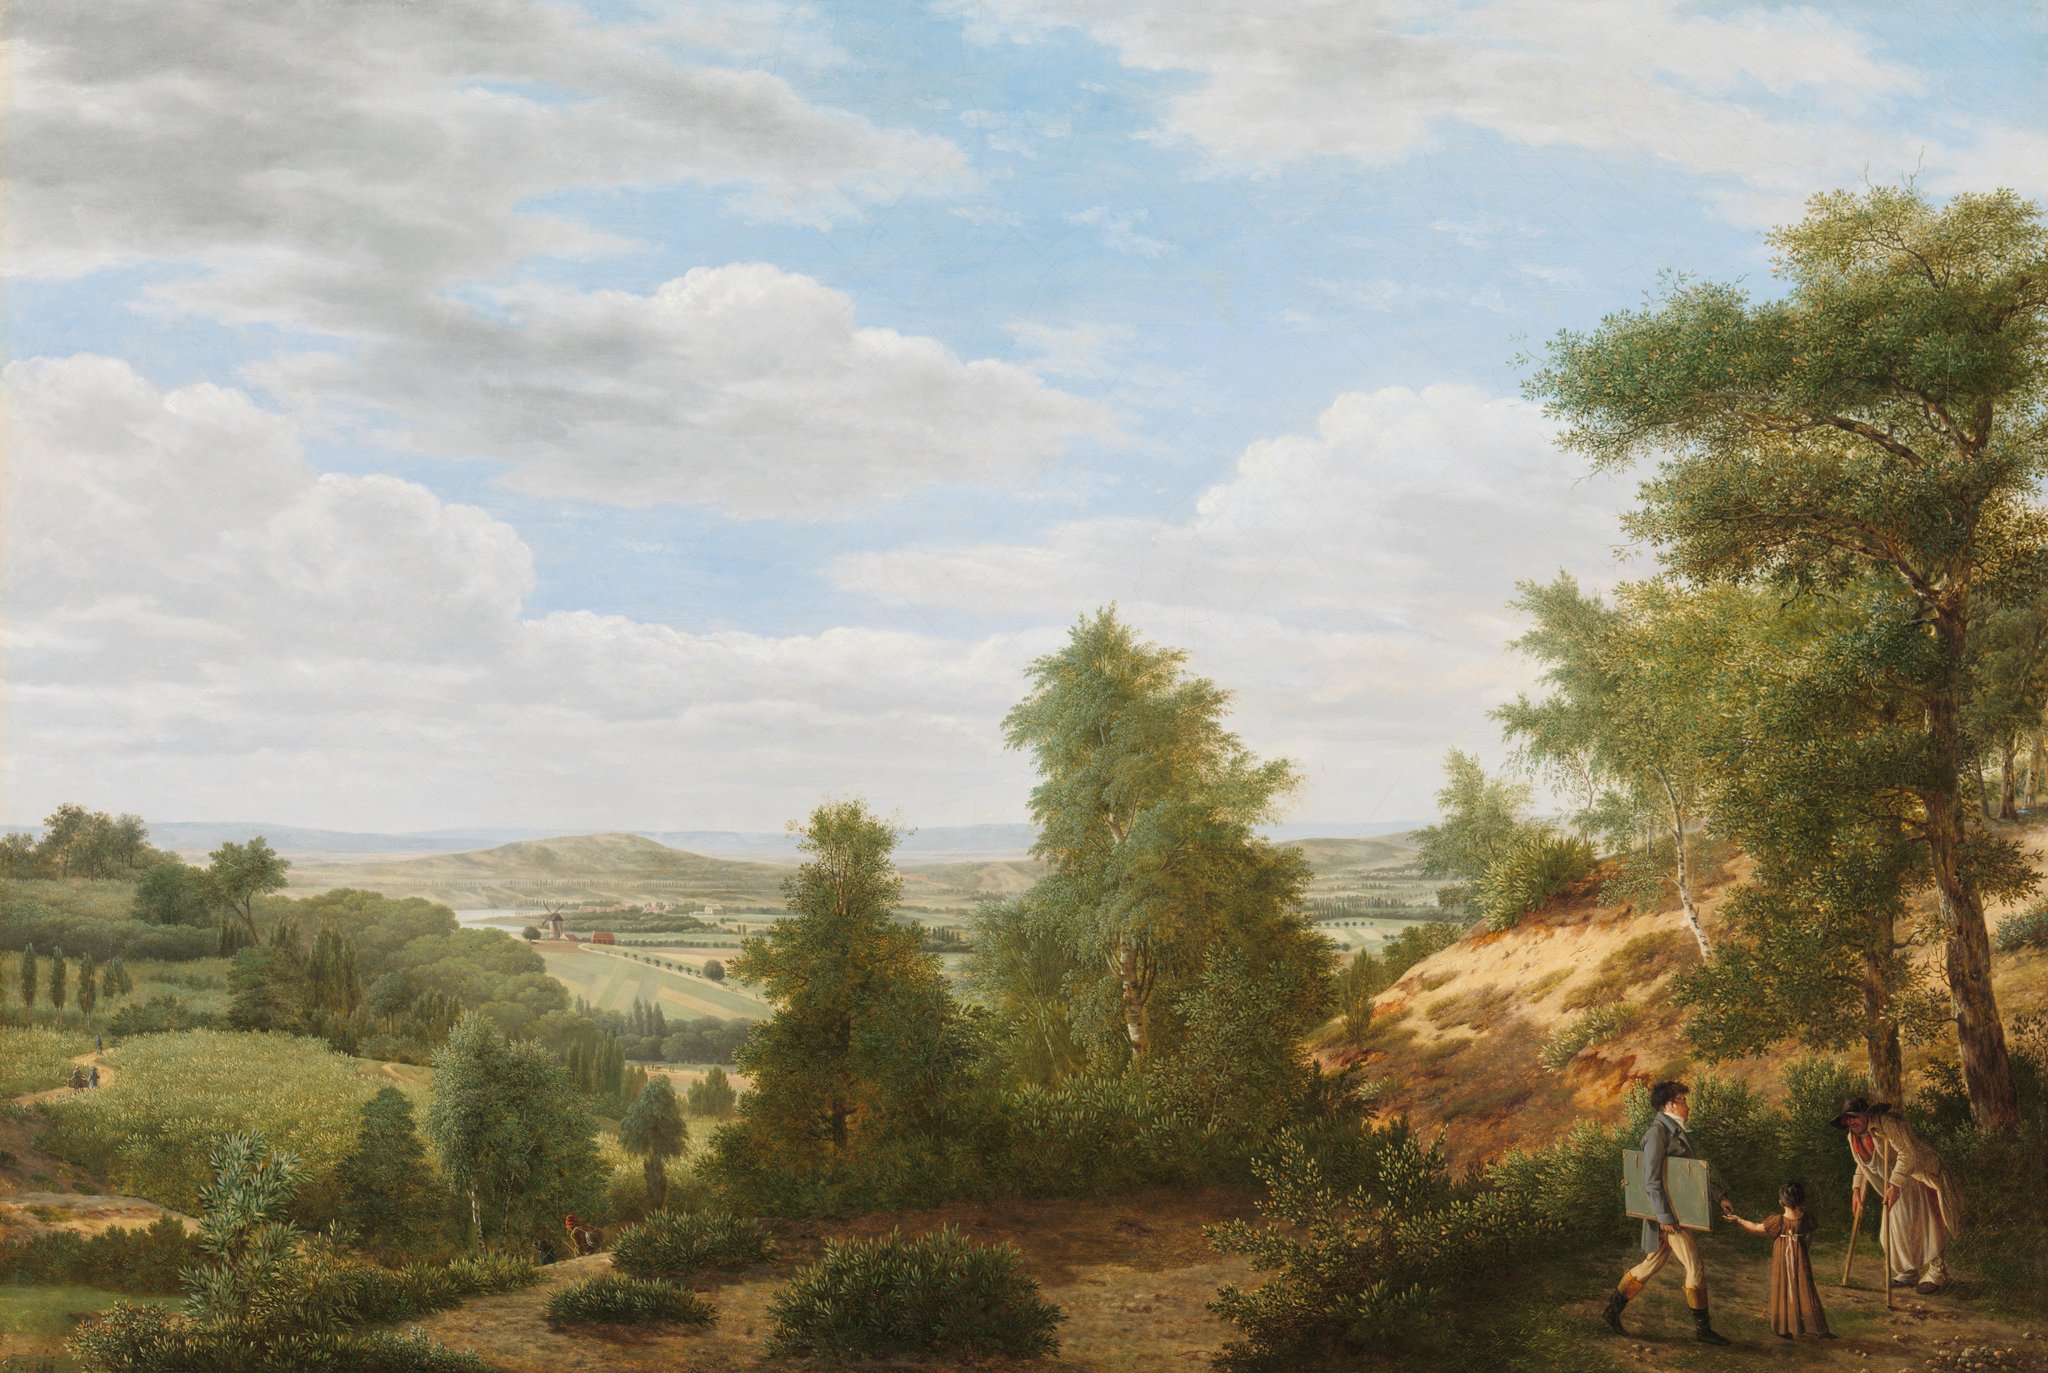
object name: painting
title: View of the Valley of Montmorency near Saint-Leu-la-Forêt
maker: pieter rudolph kleijn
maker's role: painter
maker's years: 1785-1816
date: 1808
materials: canvas, oil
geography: paris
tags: low hill country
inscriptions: signature and date: ‘P.R. Kleyn 1808’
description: From 1807 to 1809 Kleijn worked in and around Paris. Two of his landscapes from this period reveal his gratitude to Louis Napoleon. The King had bought two châteaux at Saint-Leu-la-Forêt, while his brother Napoleon owned the Château de Saint-Cloud (portrayed in the companion piece). Although this picture received great praise, it was also criticized for being too detailed and realistic. Kleijn did indeed take a grander approach in his view of Saint-Cloud.